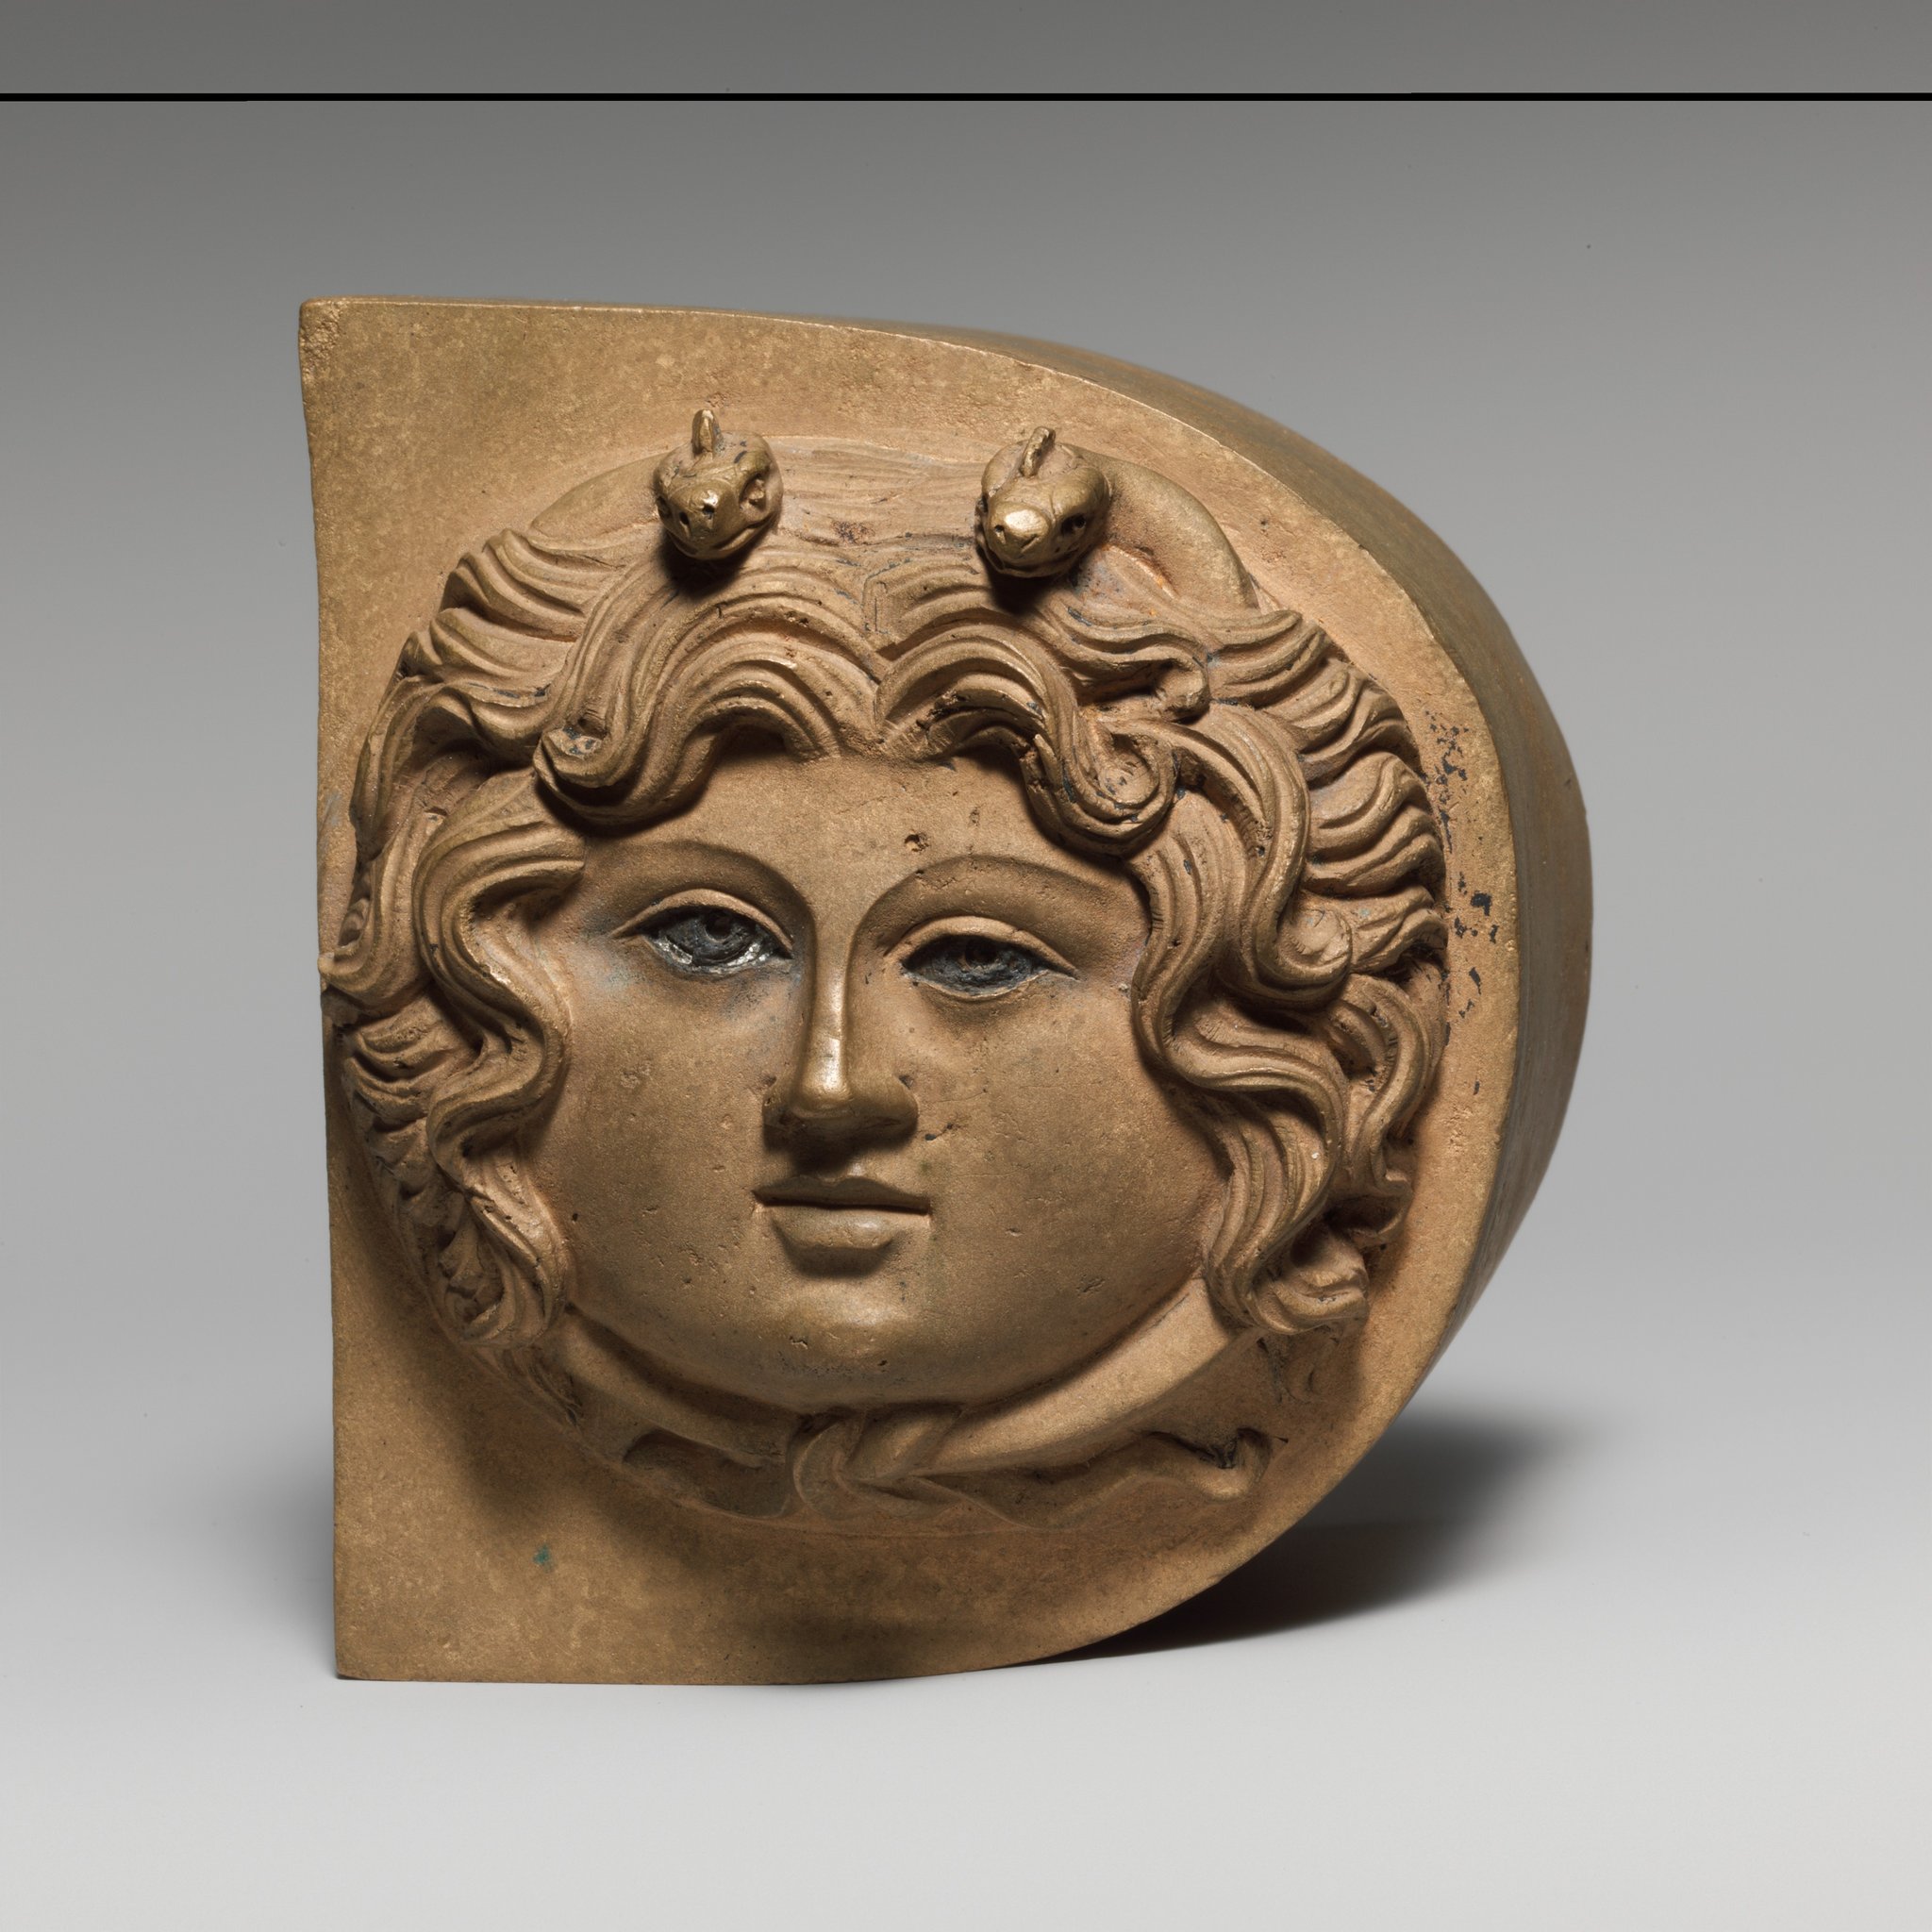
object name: boat finial with head of medusa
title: Bronze finial with the head of Medusa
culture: roman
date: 1-100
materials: bronze, silver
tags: medusa